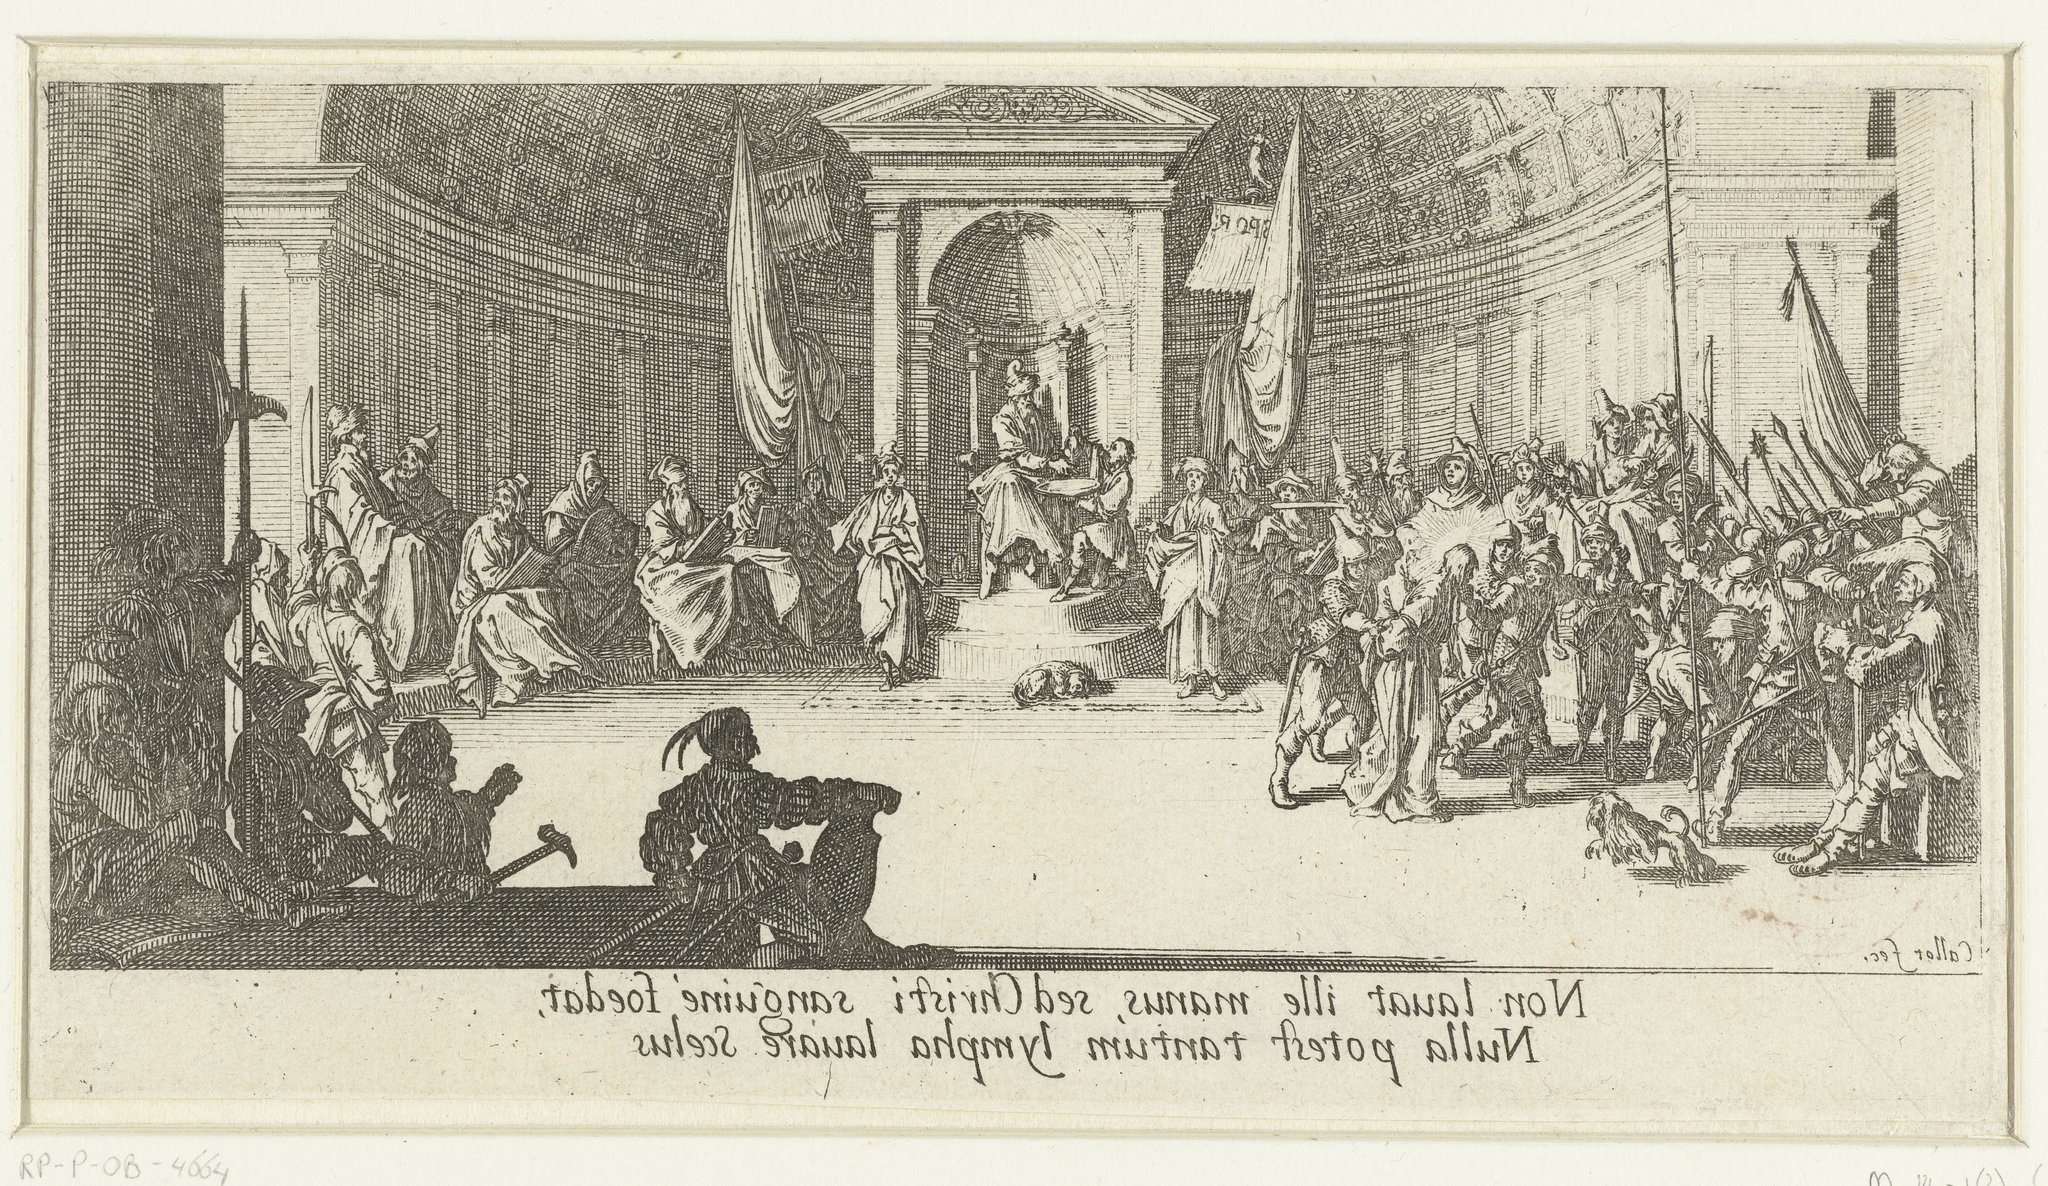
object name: print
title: De grote Passie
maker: jacques callot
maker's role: draughtsman, print maker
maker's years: 1592-1635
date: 1619-1624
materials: paper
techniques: printmaking, engraving, etching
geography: florence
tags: pilate washing his hands (in innocence)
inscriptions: collector's mark: Lugt 240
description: In een halfronde, klassiek ogende ruimte wast Pilatus zijn handen boven een schotel die een bediende voor hem vasthoudt. Christus wordt ondertussen door soldaten weggeleid. Deze prent is een tegenafdruk (contre-épreuve) van een prent die onderdeel is van de onvoltooide prentserie 'De grote Passie', bestaande uit 7 scènes uit het Lijdensverhaal.